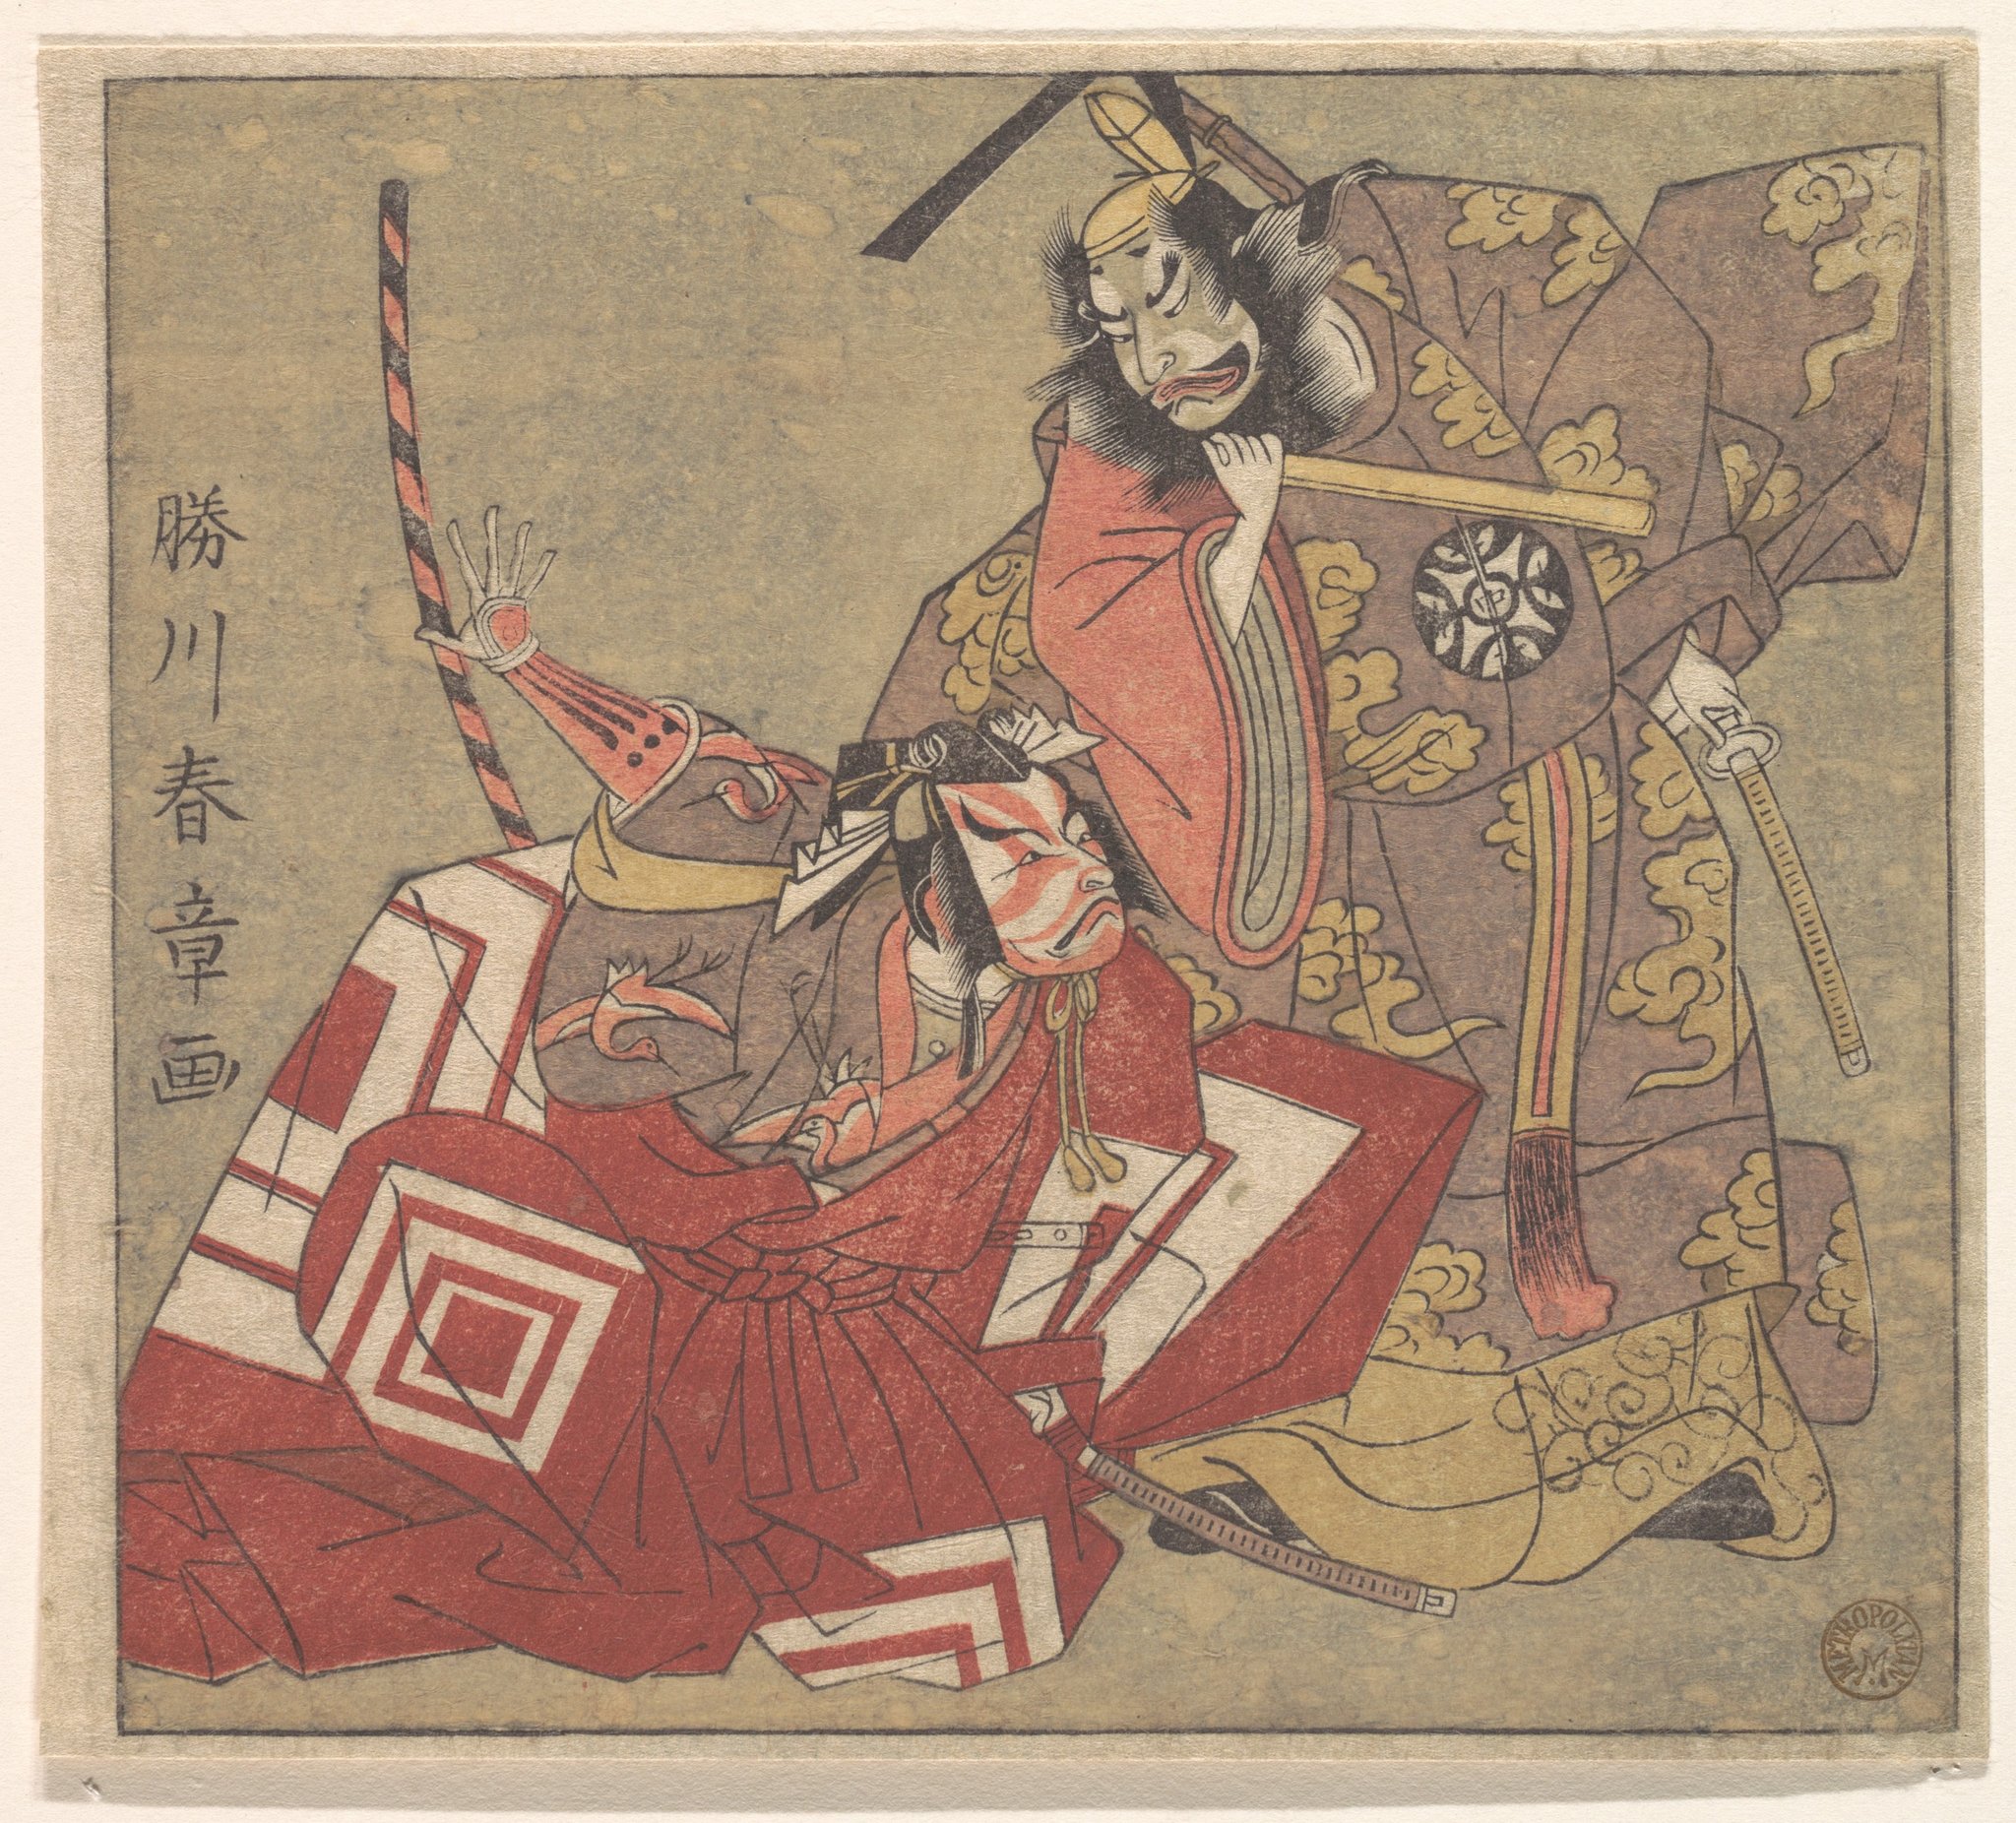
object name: woodblock print nishiki e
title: Scene from a Drama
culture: japanese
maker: katsukawa shunshō 勝川春章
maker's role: artist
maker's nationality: japanese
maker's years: 1726-1792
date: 1726-1792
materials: ink, paper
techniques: nishiki e, woodblock print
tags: swords,men,actors